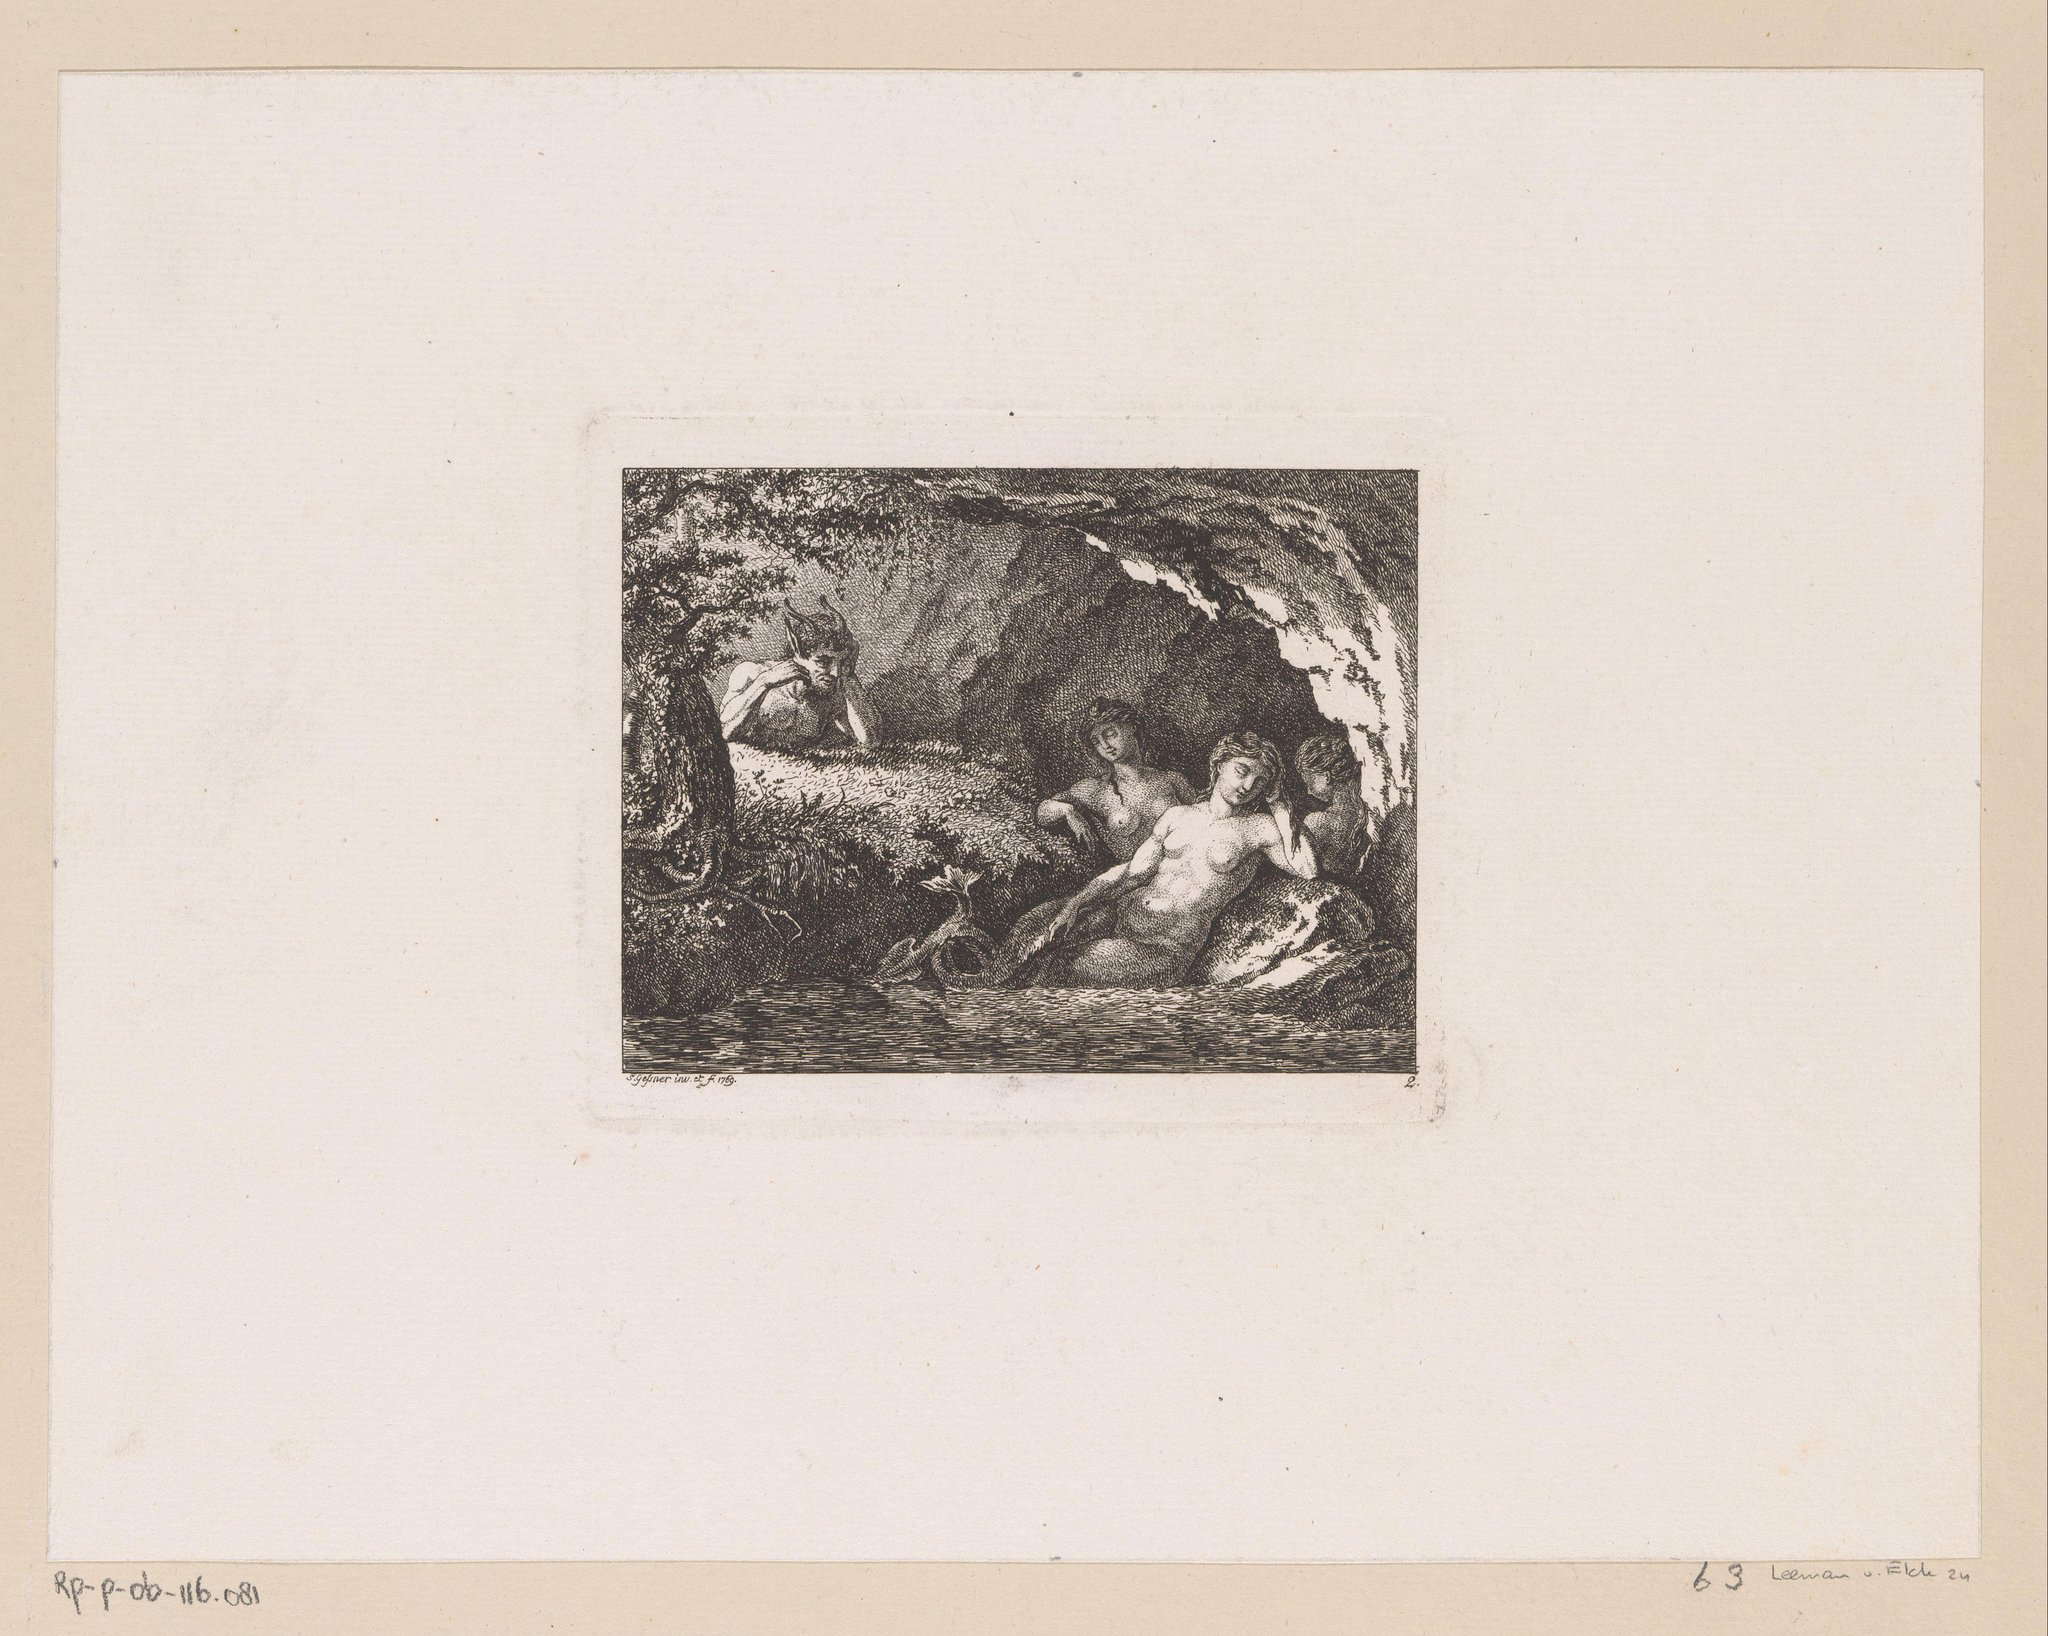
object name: print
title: Drie slapende waternimfen begluurd door een sater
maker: salomon gessner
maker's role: painter, print maker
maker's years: 1730-1788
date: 1769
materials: paper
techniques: etching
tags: satyr(s) spying upon, water meadows, sleeping; unconsciousness, naiads, river- and spring-nymphs; usually carrying an urn; 'naiadi, ninfe de' fiumi' (ripa)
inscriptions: collector's mark: Lugt 240